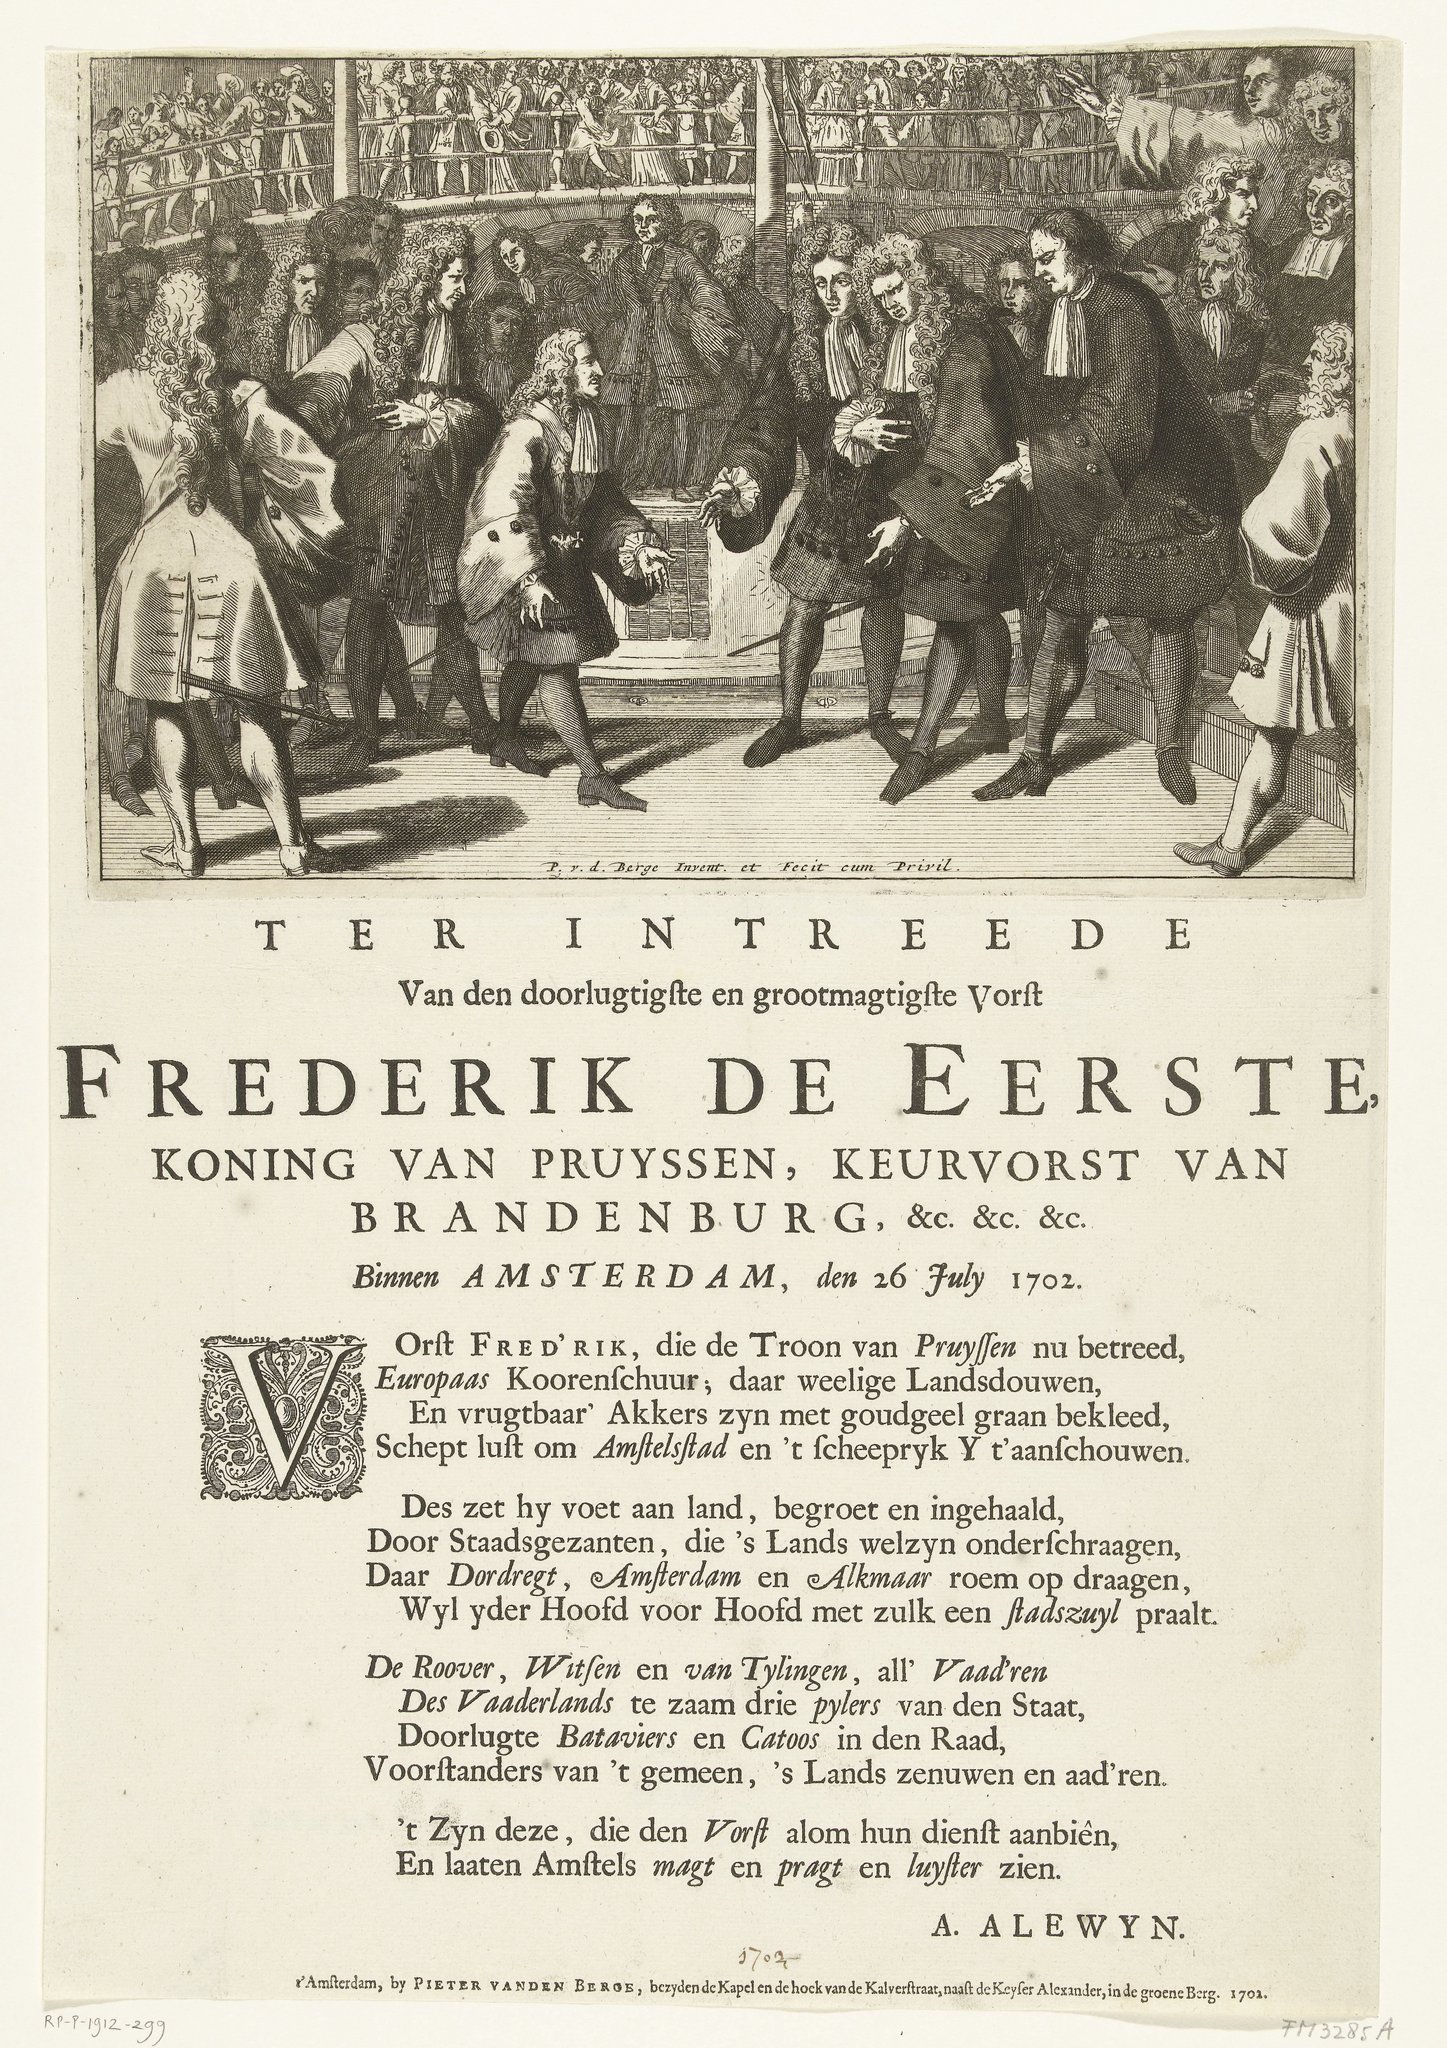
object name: print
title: Ter Intreede Van den doorlugtigste en grootmagtigste Vorst Frederik de Eerste, Koning van Pruyssen, Keurvorst van Brandenburg (...) Binnen Amsterdam, den 26 July 1702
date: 1702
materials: paper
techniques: engraving, etching, letterpress printing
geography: amsterdam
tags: amsterdam, mayor, nicolaes cornelisz. witsen, berlin, frederik i koning van pruisen, introducing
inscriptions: date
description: Bezoek van Frederik I koning van Pruisen aan Amsterdam, 26 juli 1702. De koning wordt op het dek van een schuit voor een brug ontvangen door de burgemeesters De Roever, Witsen en Teylingen. Op het blad onder de plaat een vers.